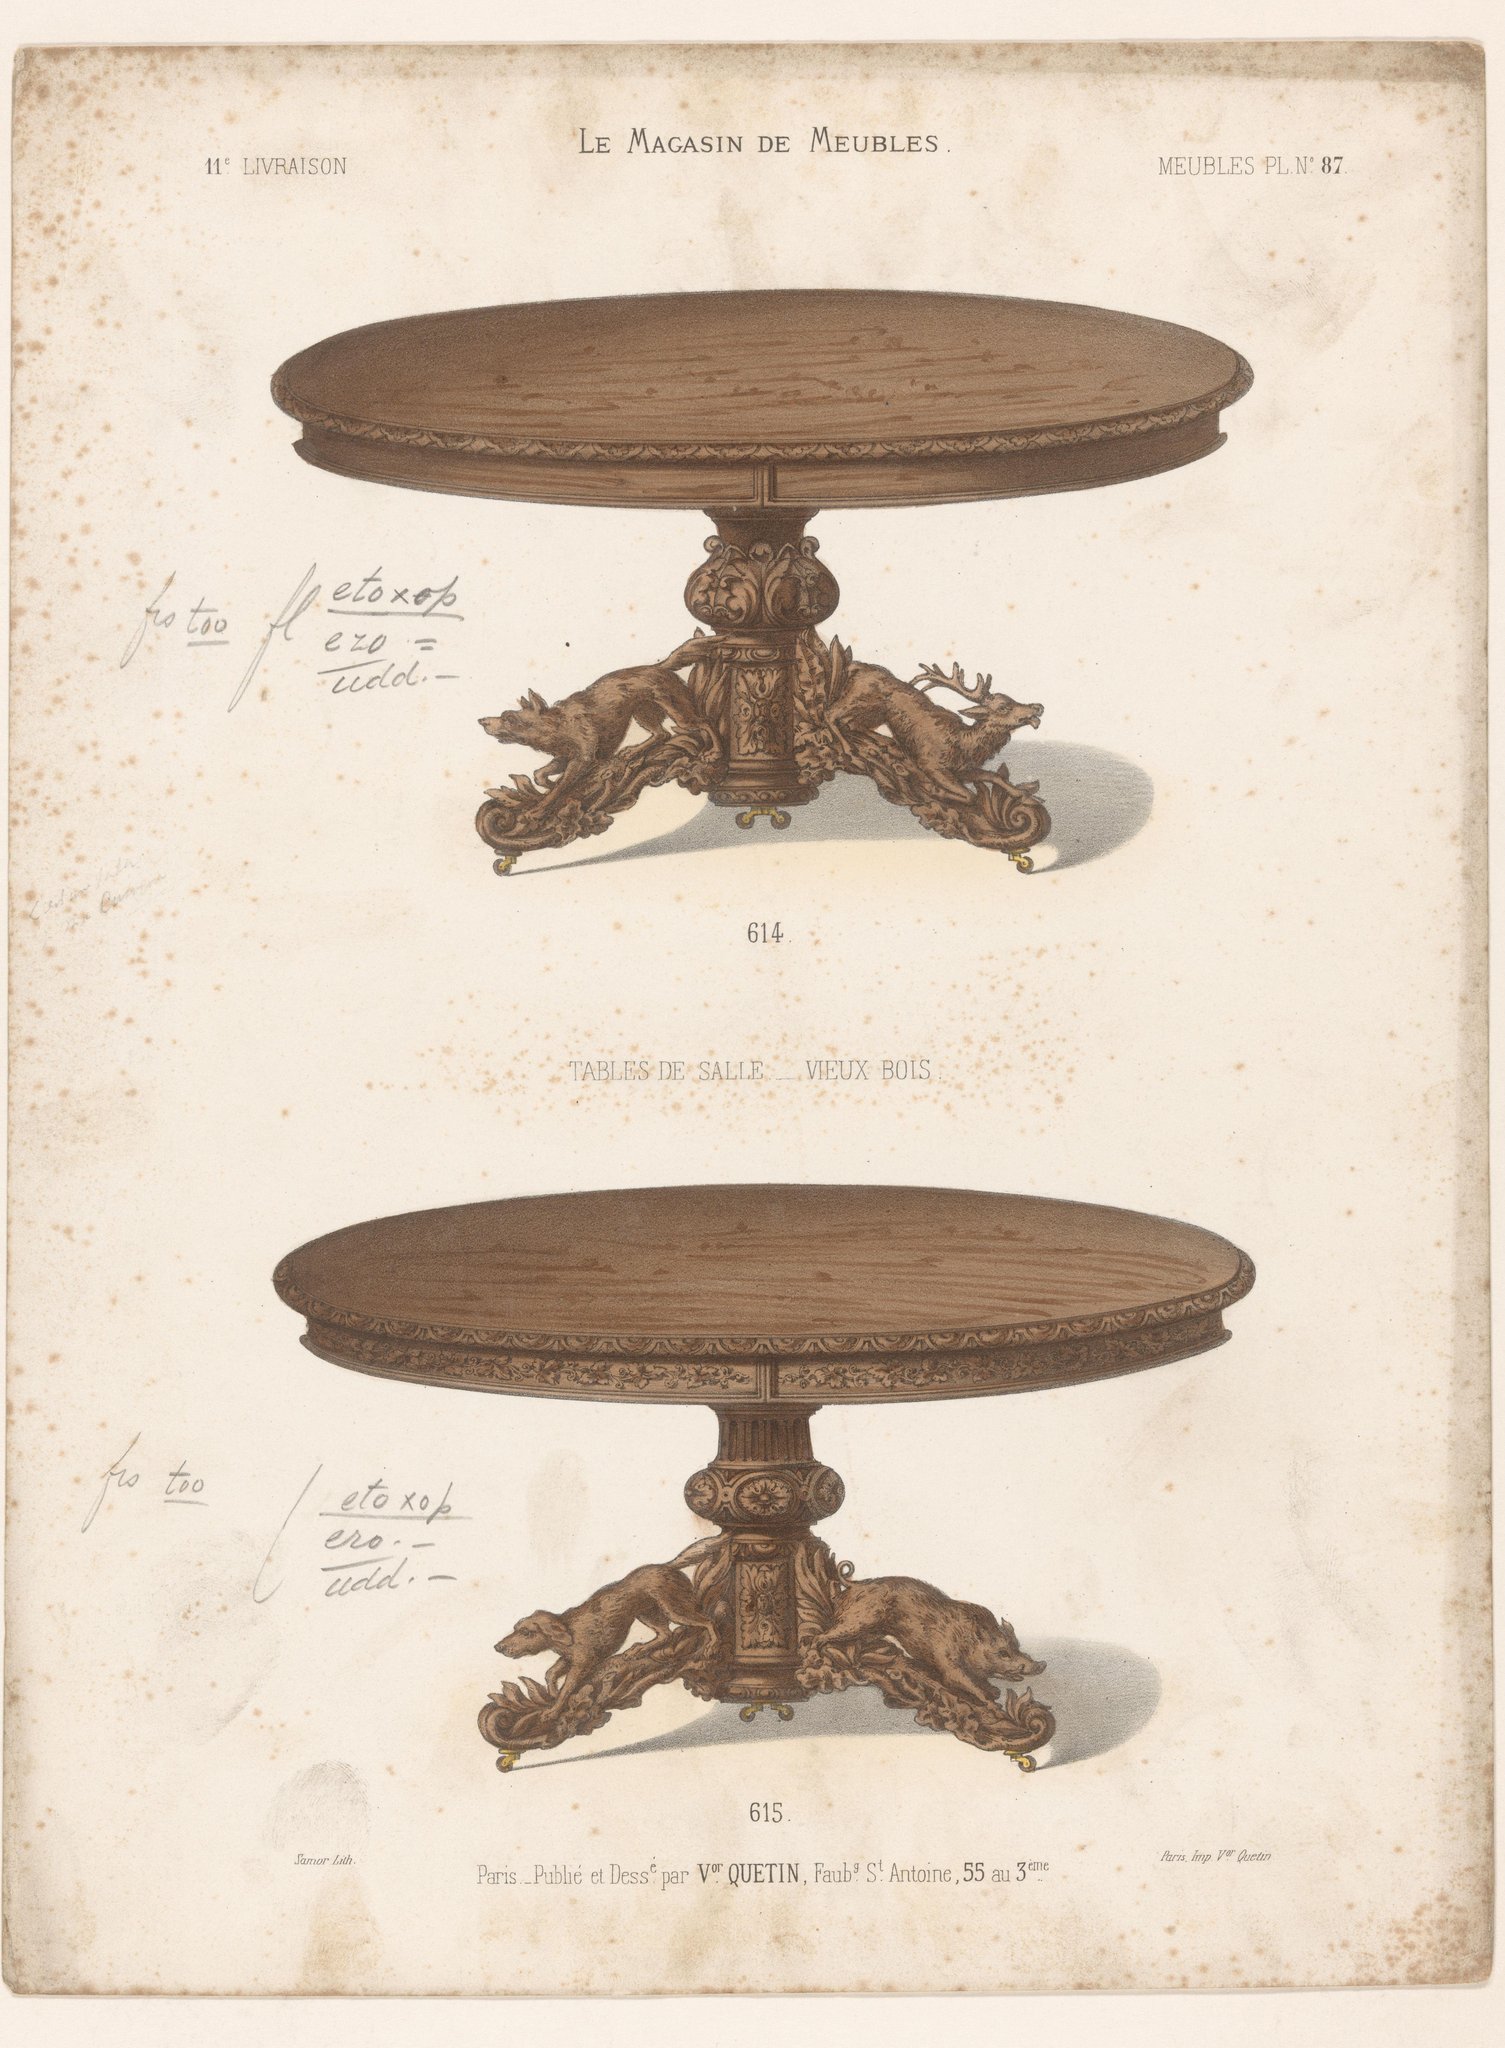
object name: print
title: Twee tafels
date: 1832-1877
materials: paper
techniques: hand coloring, lithograph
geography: paris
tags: table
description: Twee ronde tafels. Prent uit 11e Livraison.